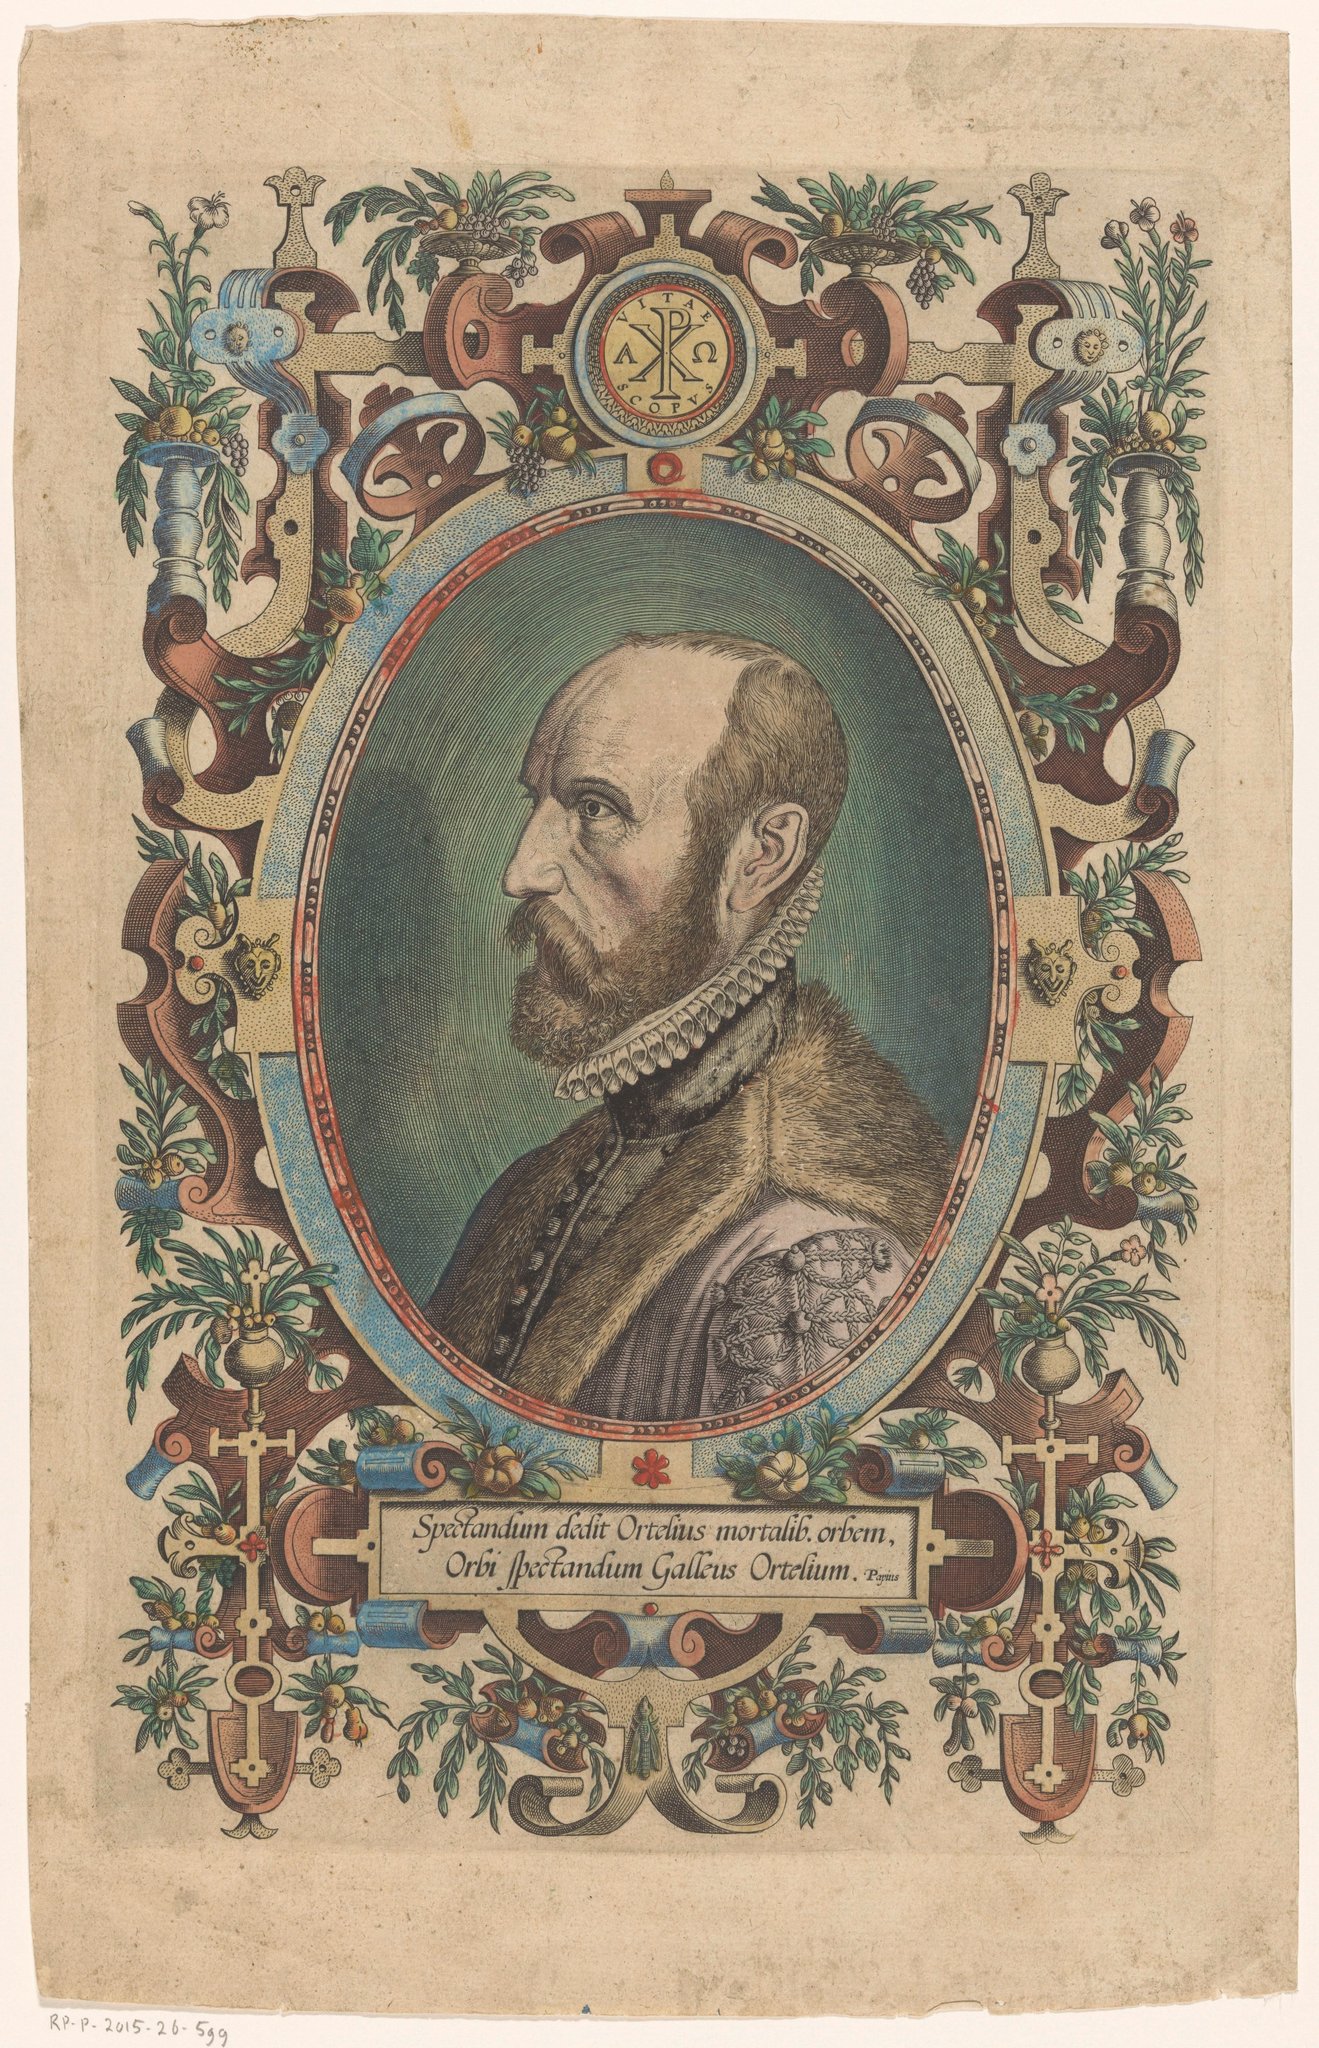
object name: print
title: Portret van Abraham Ortelius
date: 1579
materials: paper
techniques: engraving, hand coloring, letterpress printing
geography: antwerp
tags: antwerp, abraham ortelius, chrismon and derived forms ~ symbol of christ, scrollwork, strapwork ~ ornament, ornament derived from plant forms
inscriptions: collector's mark: Lugt 2228, collector's mark: Lugt 4779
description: Portret van de cartograaf Abraham Ortelius. Buste in ovaal, in omlijsting met rolwerk en planten- en bloemenmotieven. Boven het portret een medaillon met het Christusmonogram, onder het portret een cartouche met tweeregelig vers in het Latijn door Andreas Paepe.